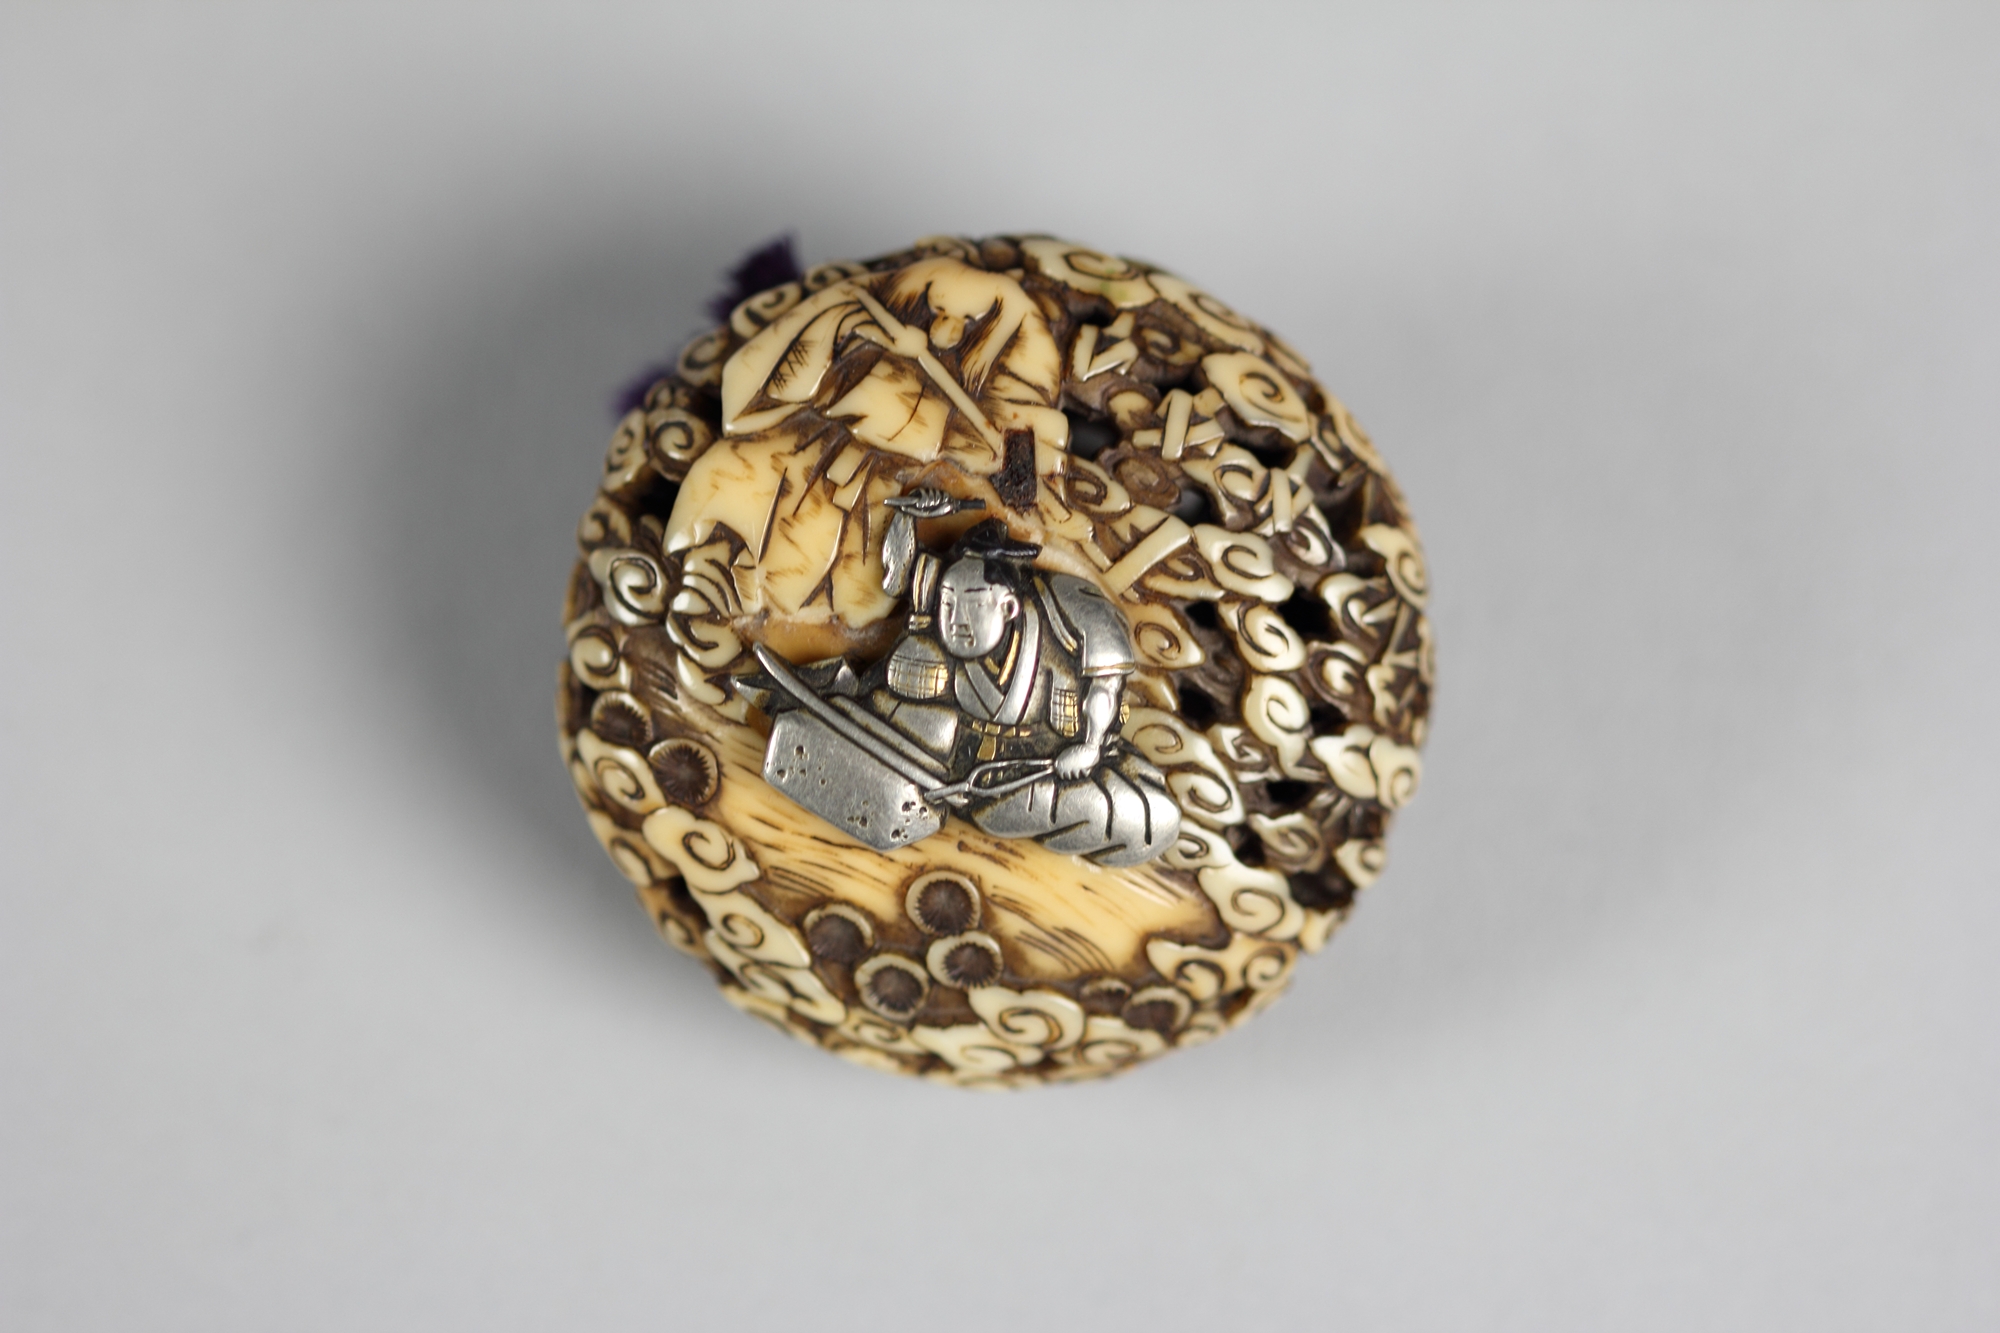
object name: netsuke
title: Netsuke of Munechika Forging Blade "Little Fox"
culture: japanese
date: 1801-1900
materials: ivory, silver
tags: men,tools